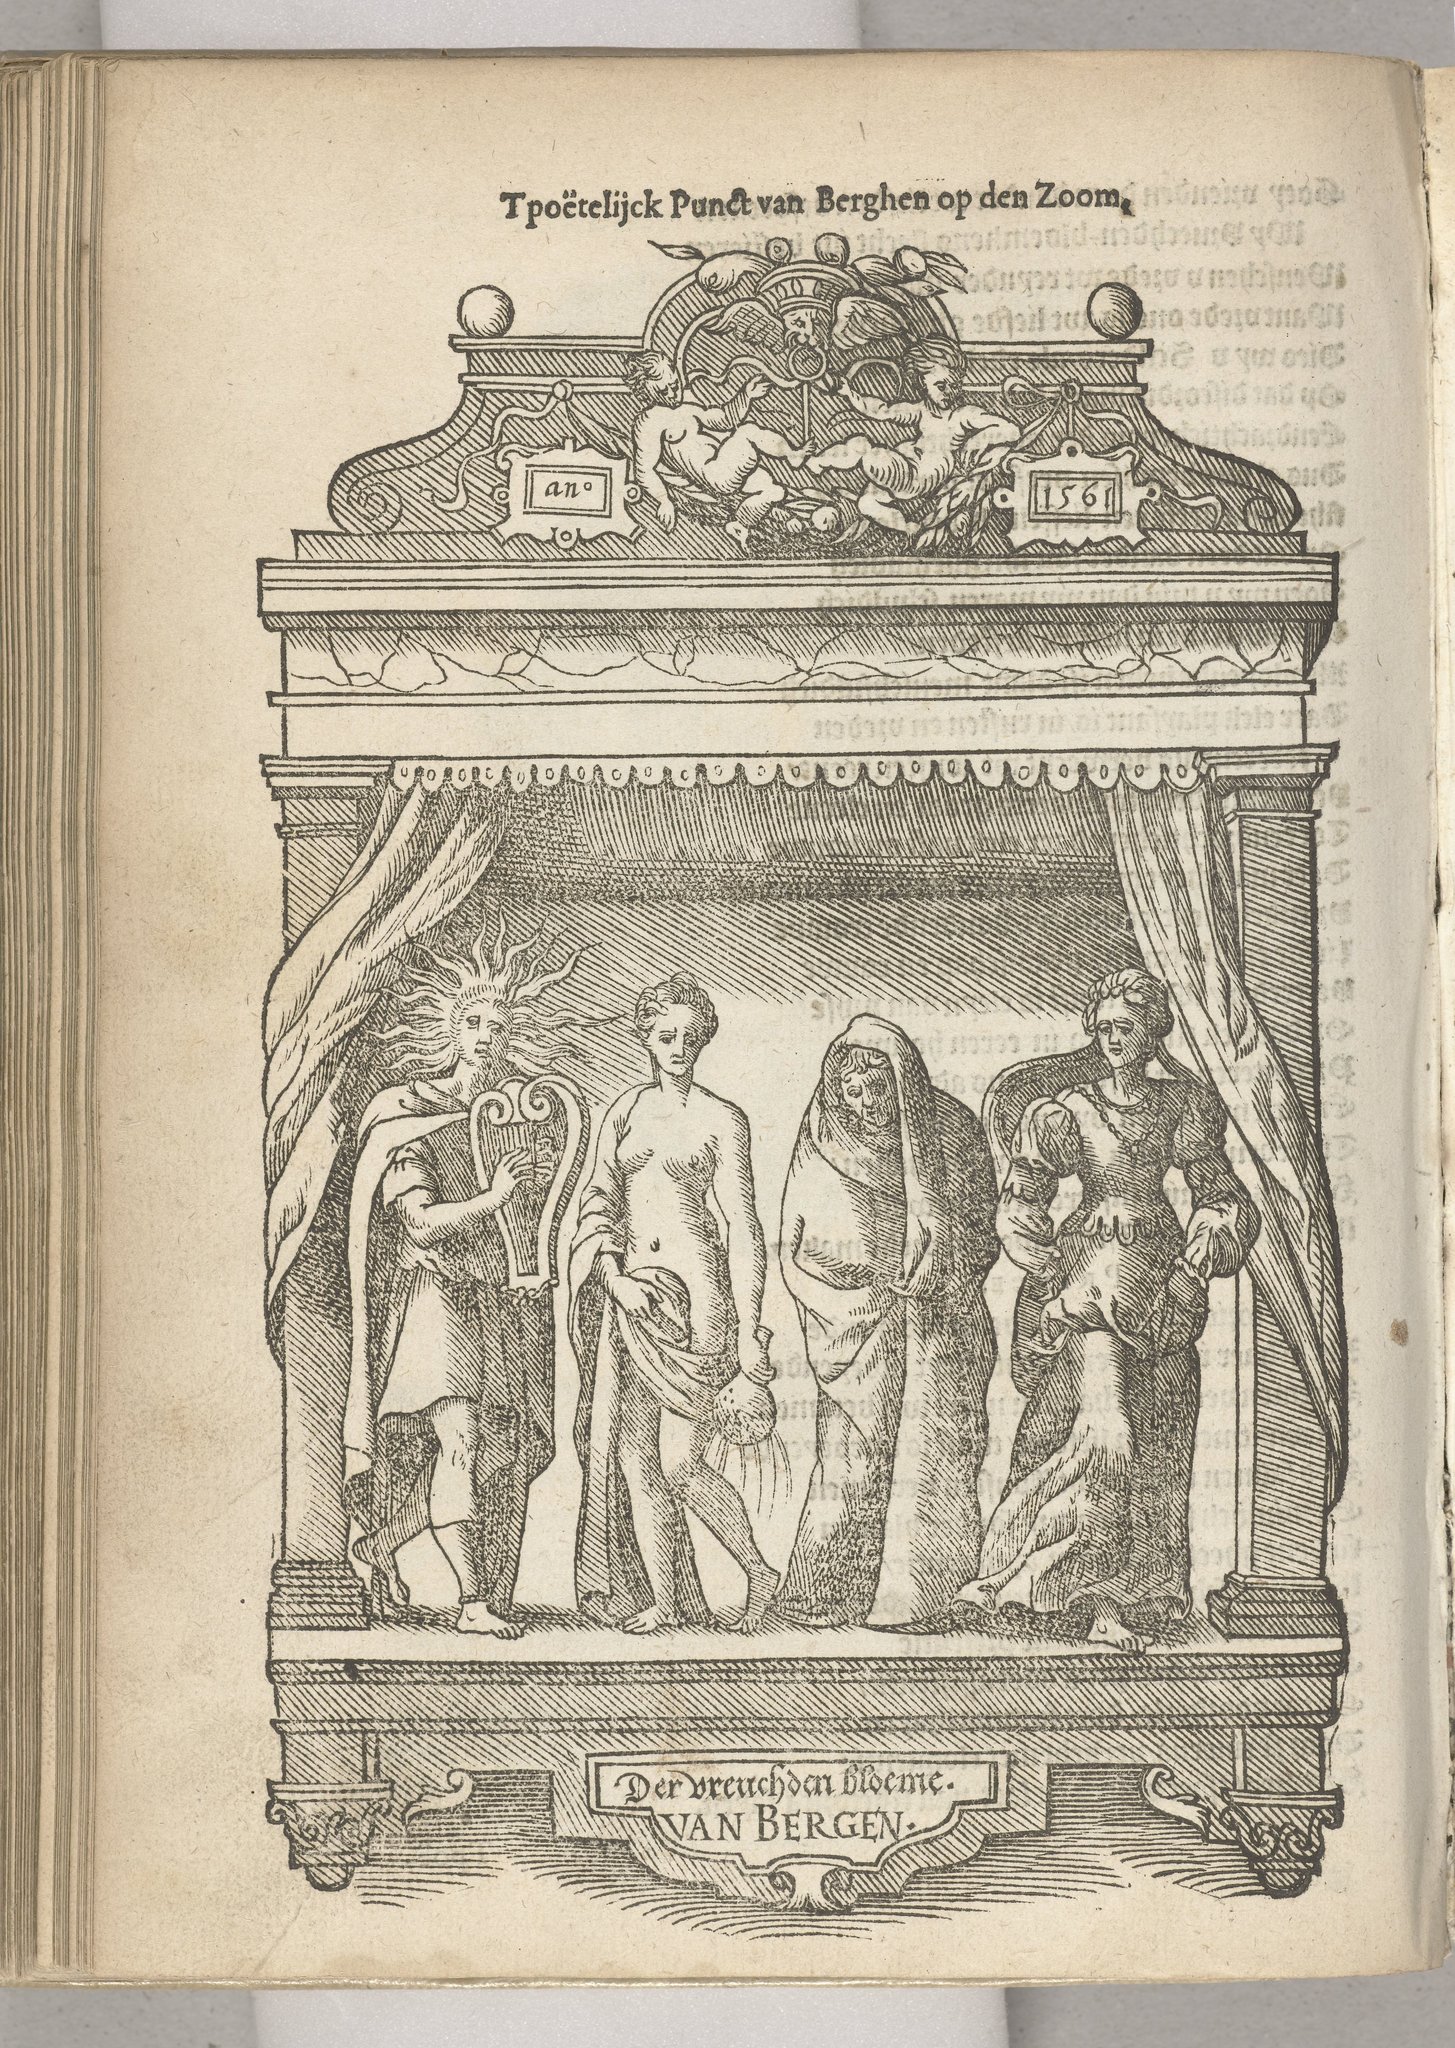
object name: print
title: De Lelie Bloeme van Diest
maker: Anonymous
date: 1561-1562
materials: paper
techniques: woodcut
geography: antwerp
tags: chamber of rhetoric (dutch: 'rederijkerskamer'), antwerp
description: Illustratie in: Spelen van sinne vol scoone moralisacien wtleggingen ende bediedenissen op alle loeflijcke consten waer inne men claerlijck ghelijck in eene spieghel, figuerlijck, poetelijck en retorijckelijck mach aenschouwen hoe nootsakelijck ende dienstelijck die selve consten allen menschen zijn : ghespeelt met octroy der Con. Ma. binnen der stadt van Andtwerpen op dLant-Juweel by die veerthien cameren van Retorijcken die hen daer ghepresenteert hebben den derden dach Augusti int Jaer ons Heeren 1561, op die questie : wat den mensch aldermeest tot conste verwect. Uitgave van 1562, p. Dd (2) verso. In het exemplaar in de Rijksmuseum Research Library, signatuur: 325 D 20.